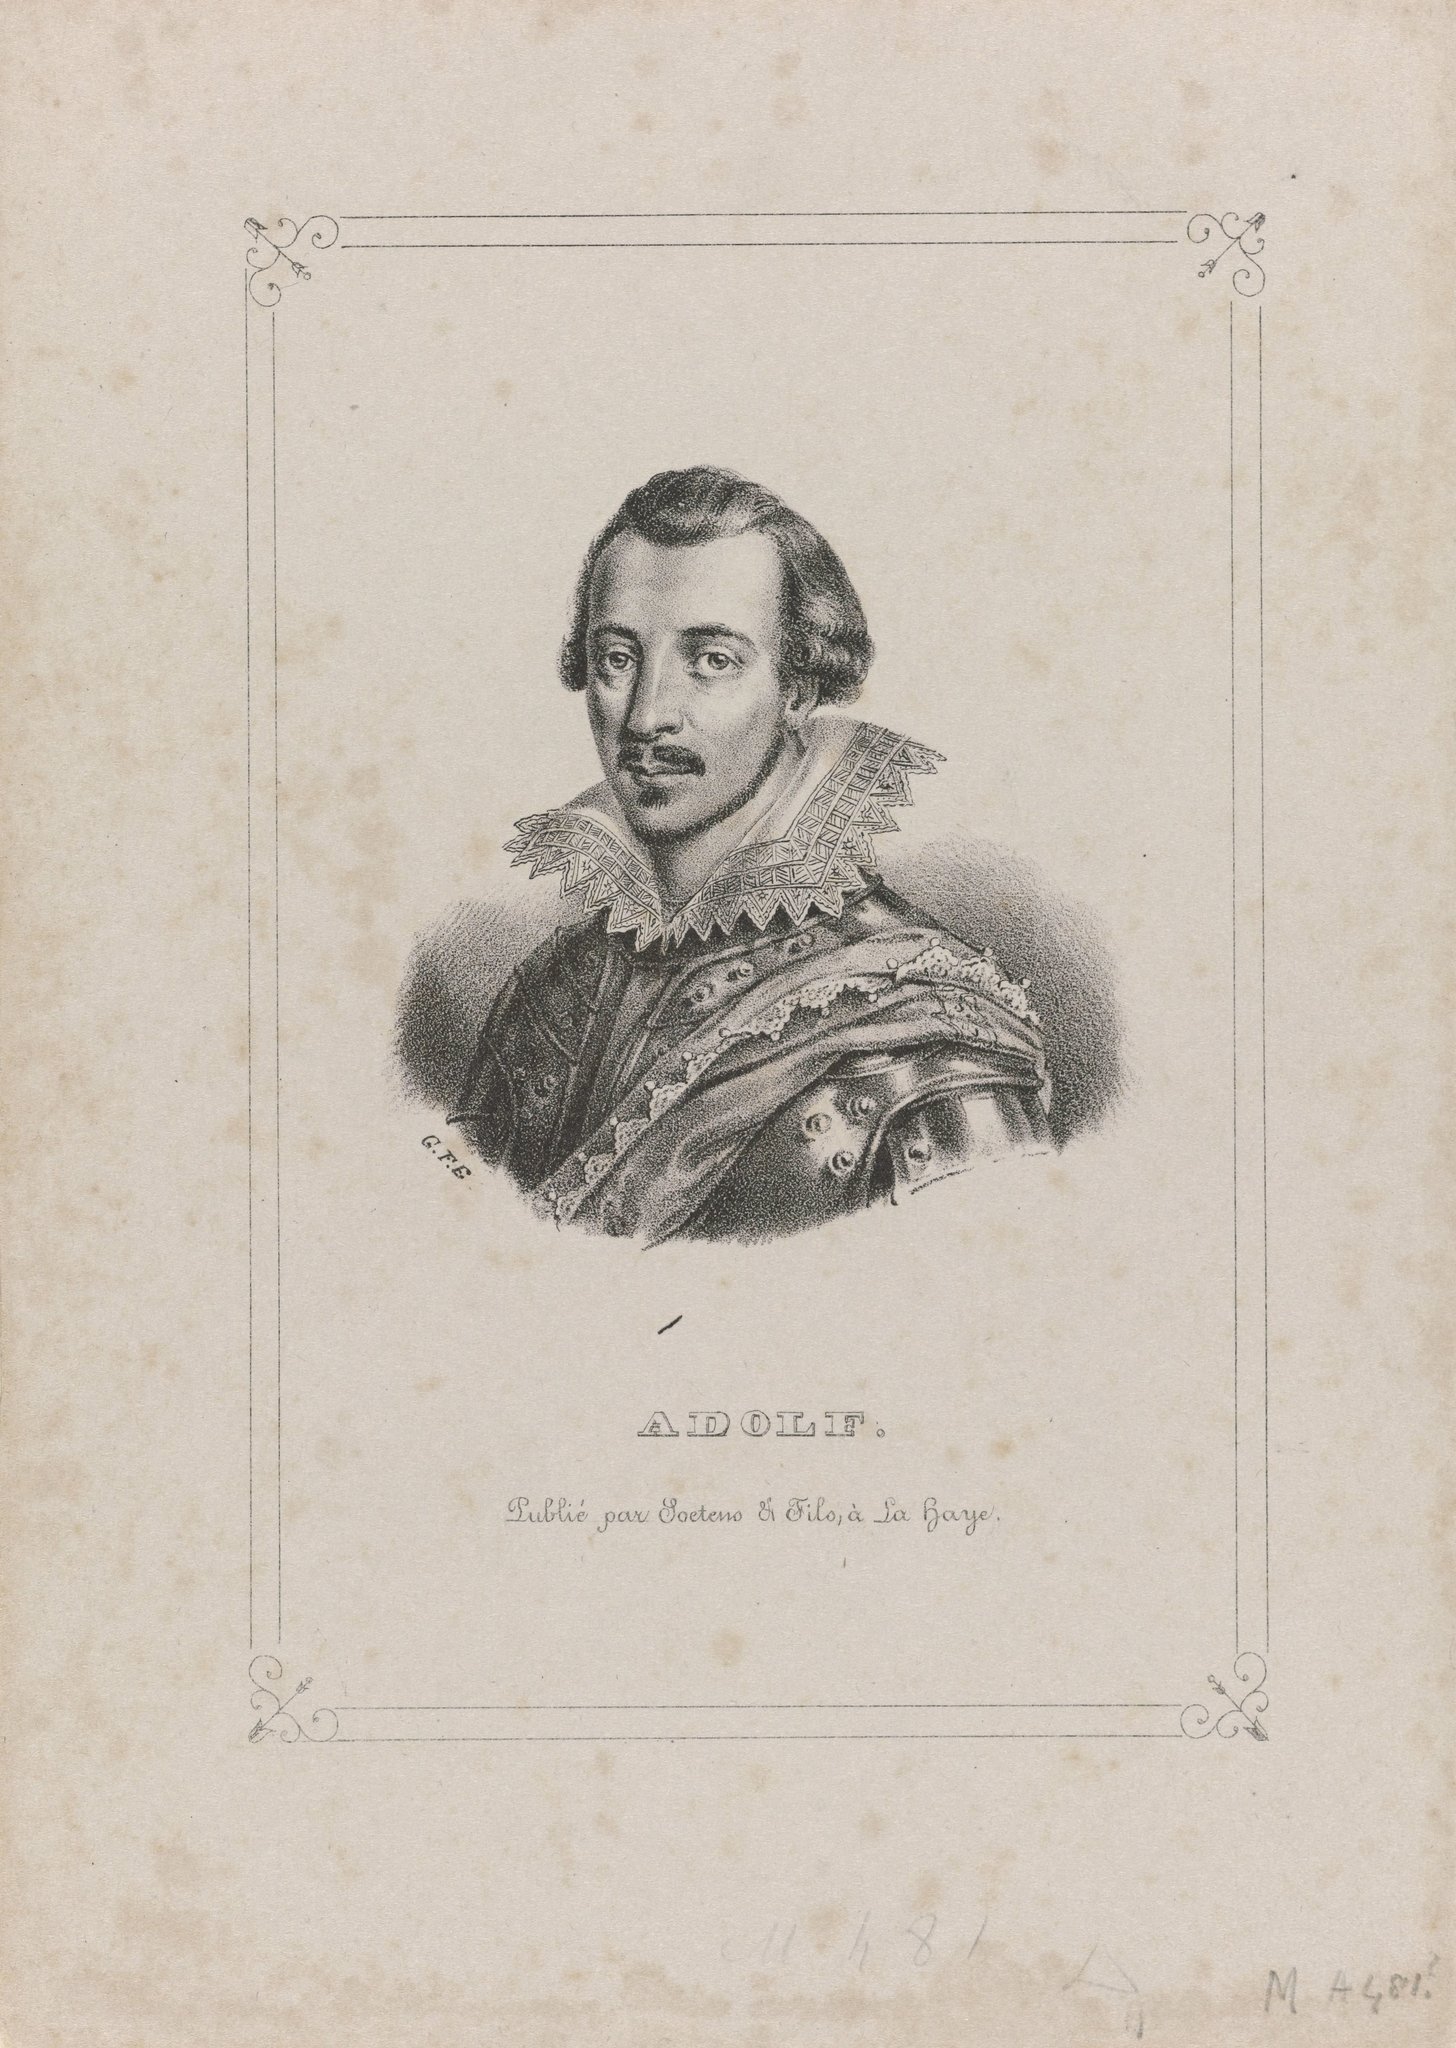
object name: print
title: Portret van Adolf, graaf van Nassau-Siegen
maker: gerhardus fredericus eilbracht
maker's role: draughtsman, print maker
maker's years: 1816-1854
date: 1837-1840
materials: paper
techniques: lithograph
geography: the hague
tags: earl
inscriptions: collector's mark: Lugt 2166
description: De hier vermelde titel verwijst naar de hoogst verkregen titel van de geportretteerde, niet per se naar de titel die de geportretteerde op deze voorstelling draagt.